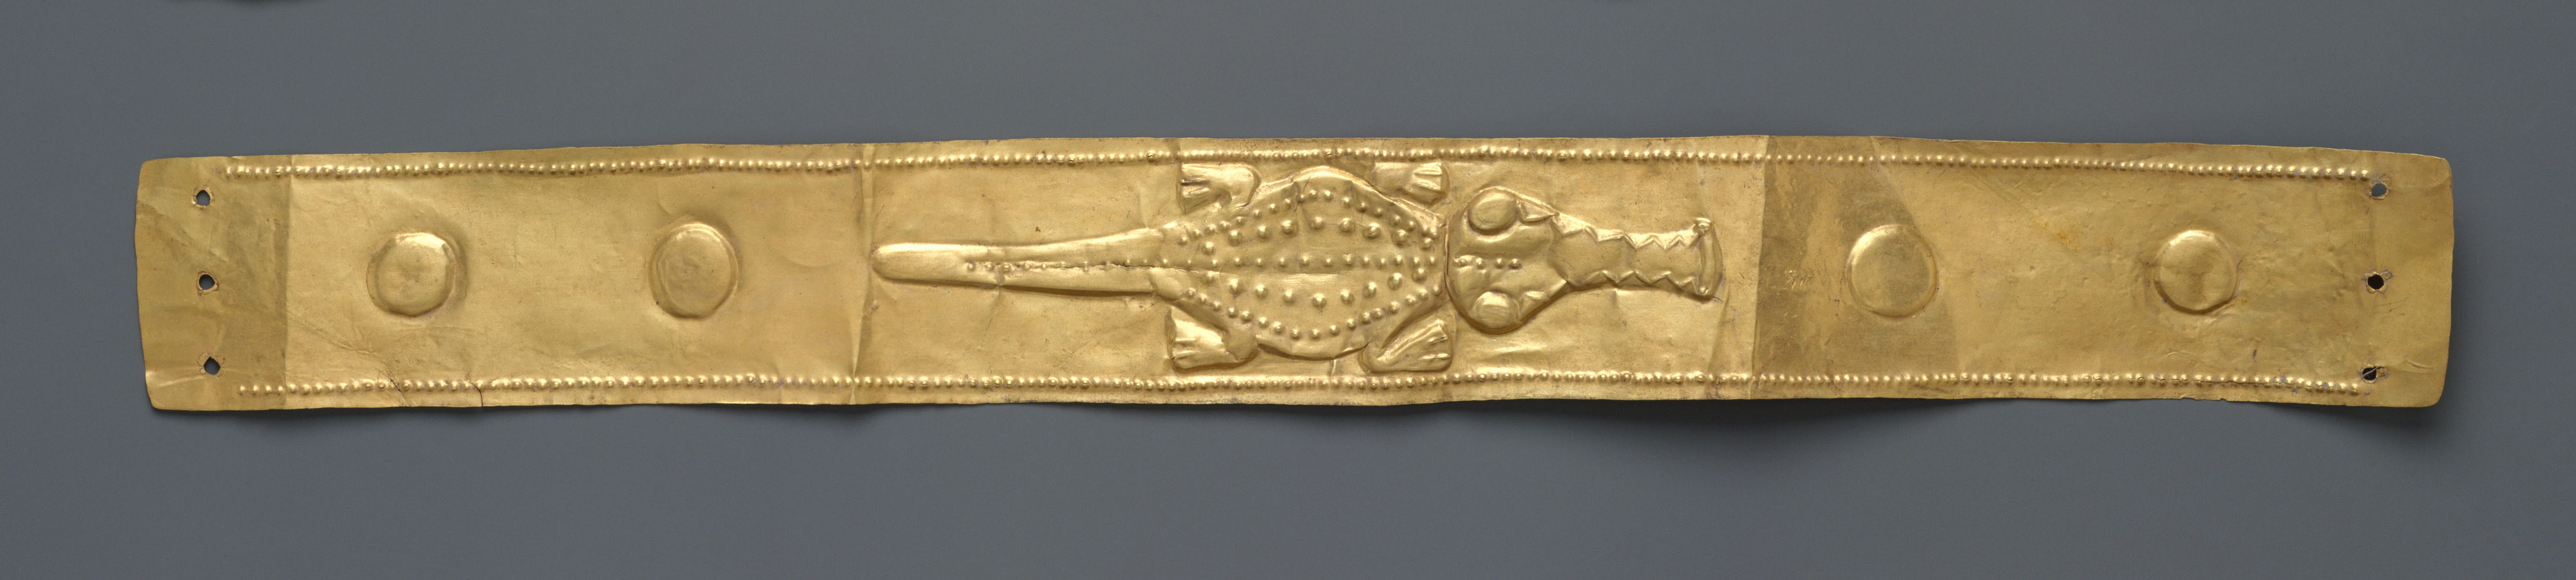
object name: diadem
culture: middle magdalena river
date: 401-1000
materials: gold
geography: colombia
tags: diadems